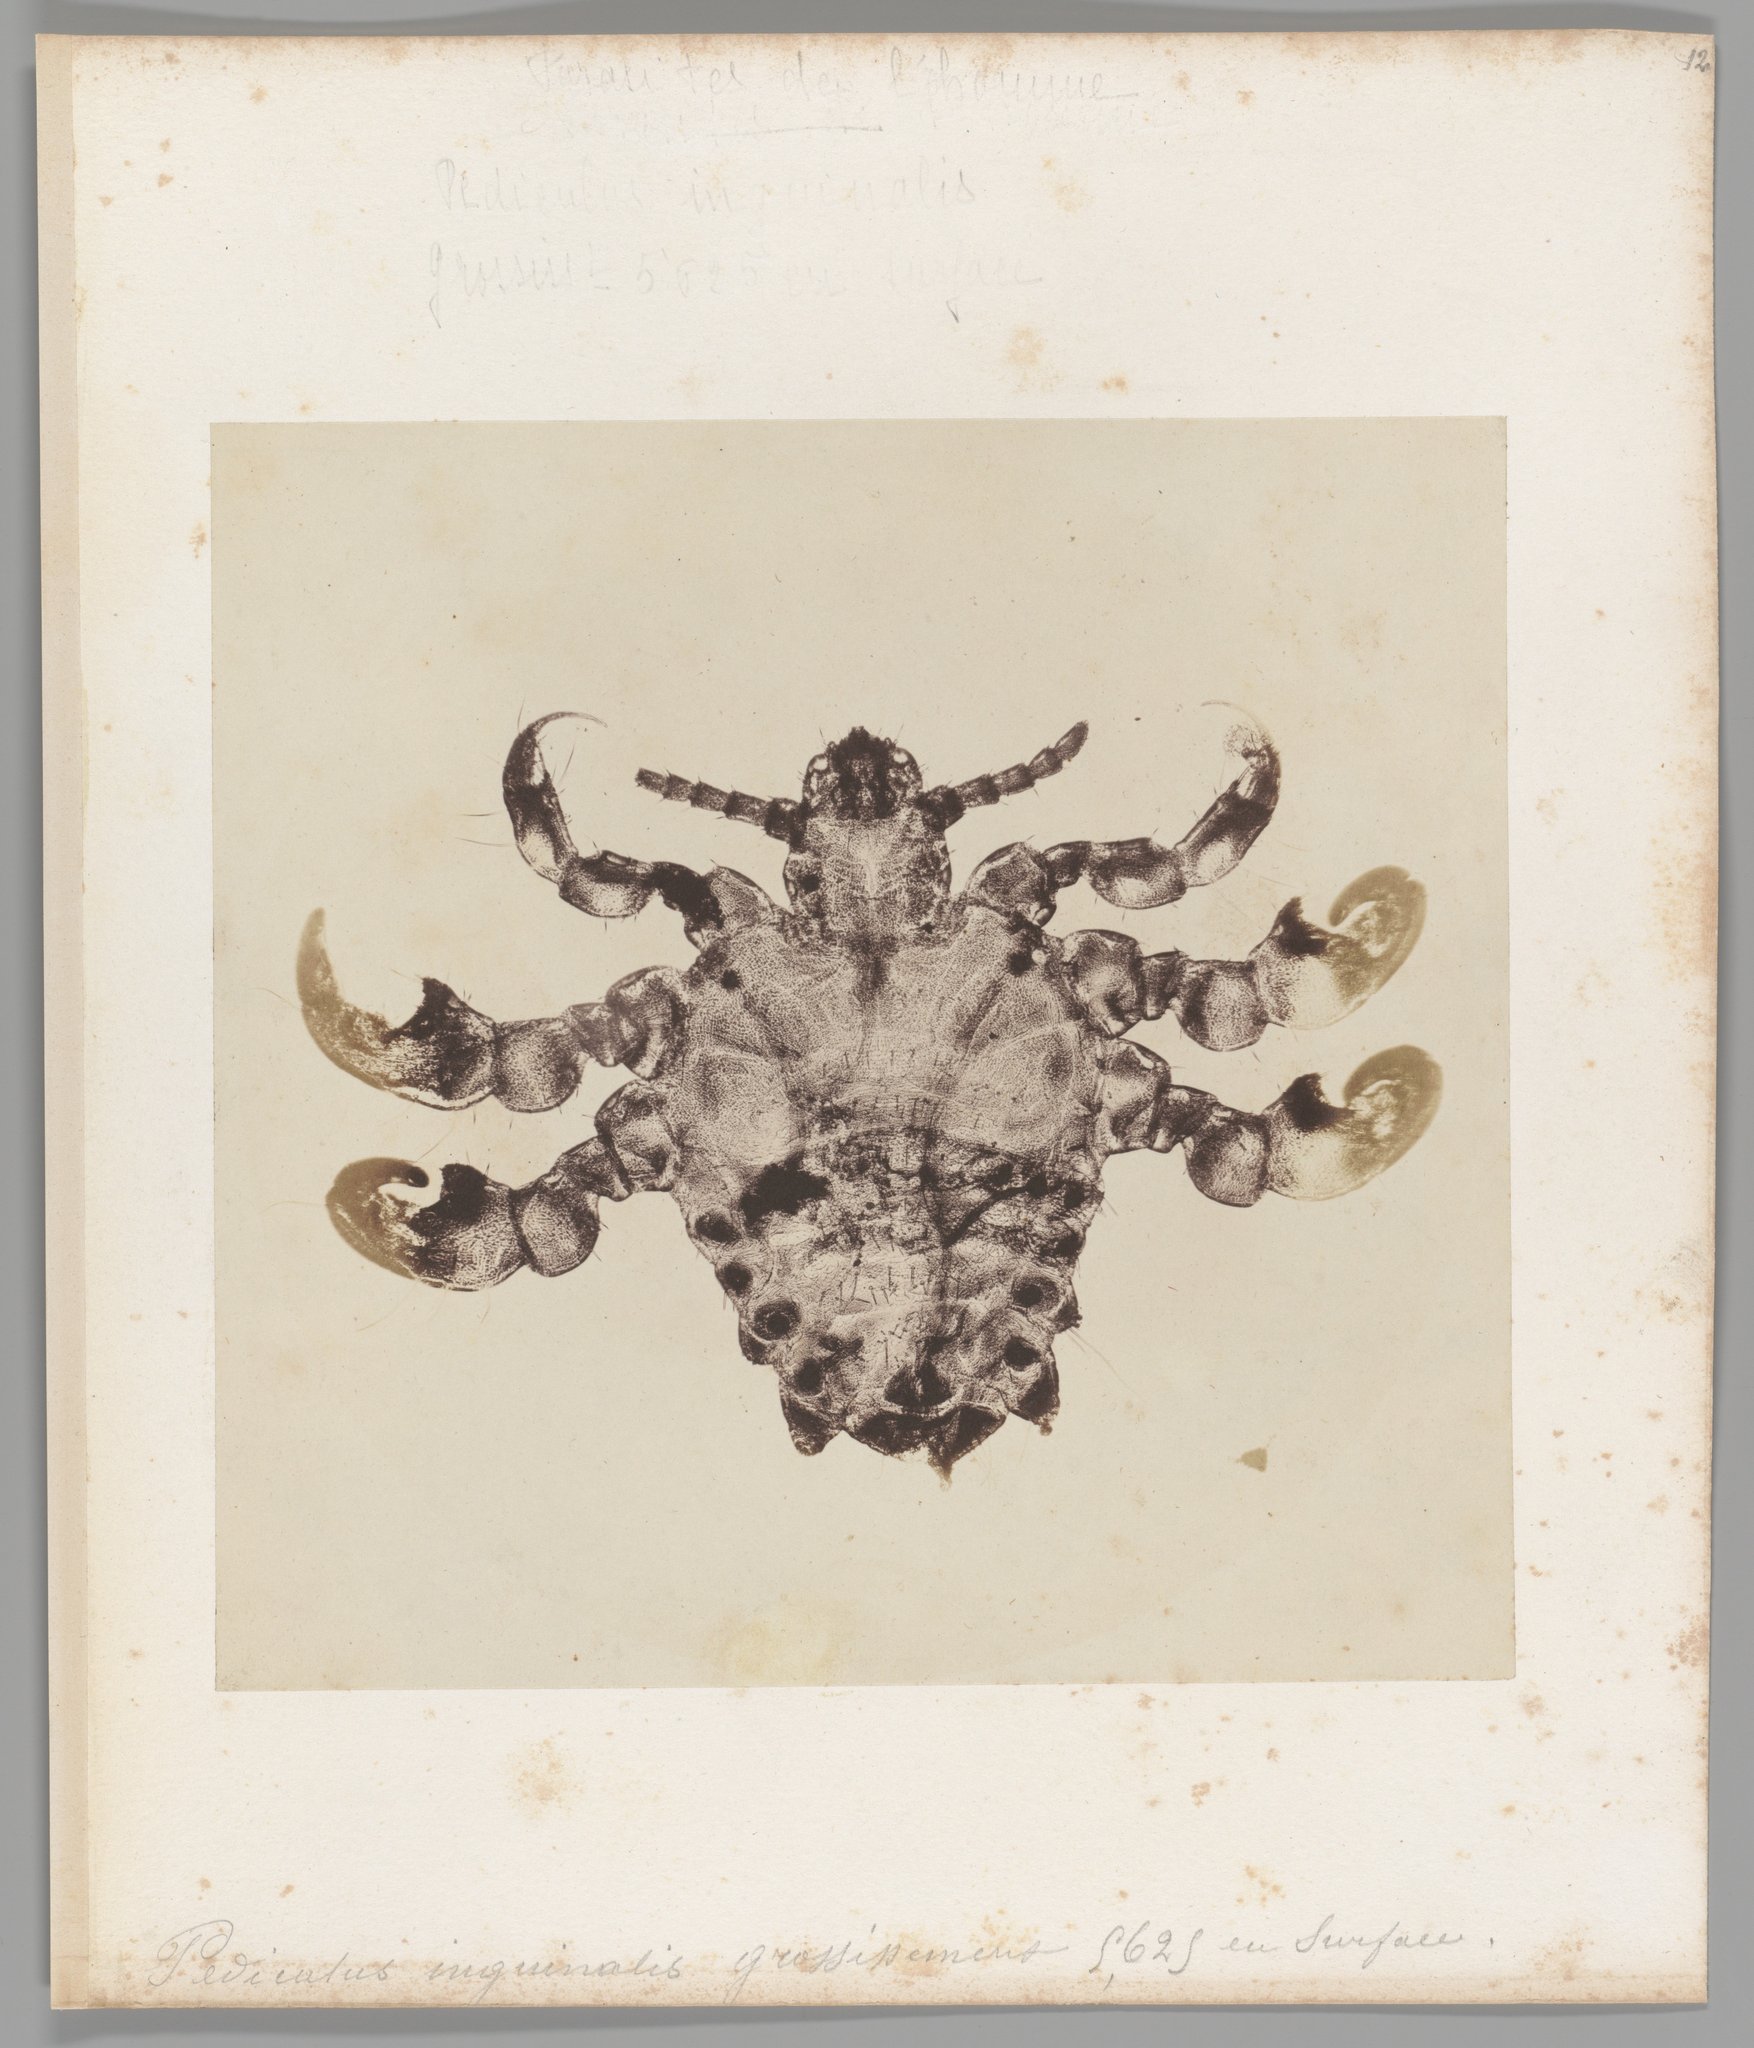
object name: photograph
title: [Untitled]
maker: auguste-adolphe bertsch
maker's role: artist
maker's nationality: french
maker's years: 1813-1871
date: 1853-1857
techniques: salted paper print